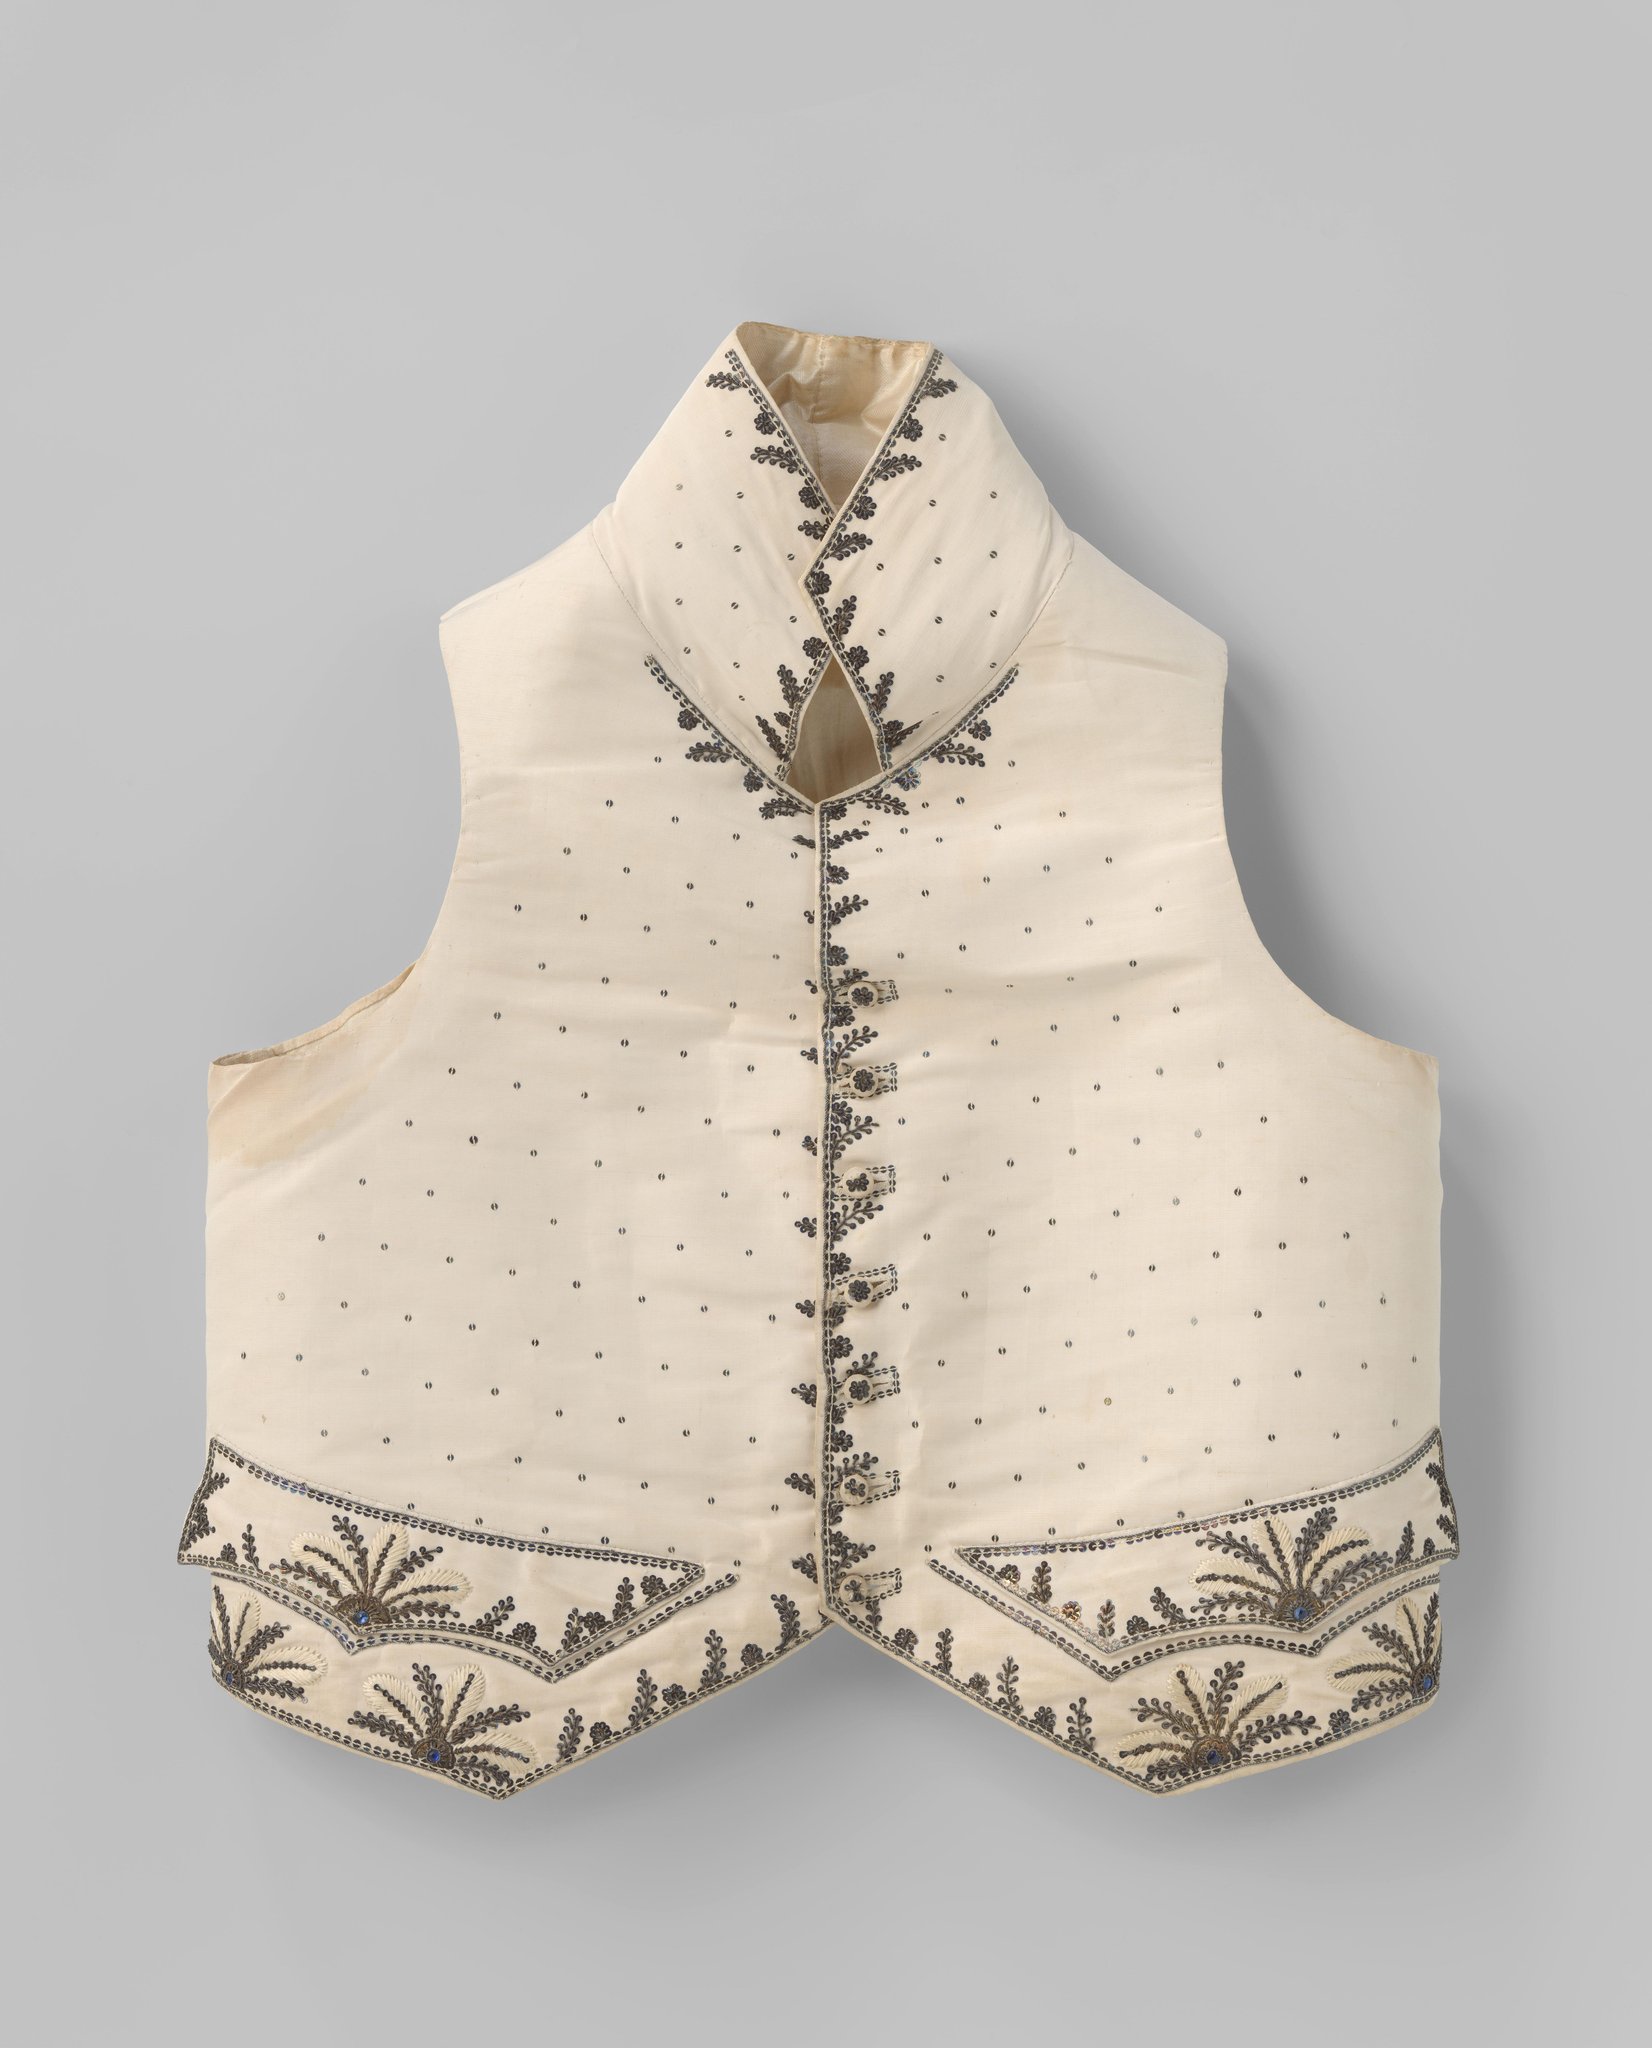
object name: main garment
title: Galavest met hoge staande kraag, schijnzakken met klep en zeven stofknopen van witte ripszijde, geborduurd met zilverkleurige lovertjes, witte zijde en blauwe stenen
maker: Anonymous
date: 1805-1810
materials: linen, silk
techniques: embroidered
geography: amsterdam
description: Galavest van witte ripszijde, gebroduurd met zilveren lovertjes, witte zijde en bauwe stenen. Model: kort, recht, met schuin weggesneden hoeken, hoge staande kraag, zeven stofknoopjes, brede, maar loze zakken met hoe geschulpte kleppen. Patroon v.h. bord w. voorzijde geheel bestrooid met losse lovertjes. Randen met blad en rozetje, met de nerven van cannetille, kleppen en odnerranken met palmetmotief in welks hart een blauw steentje zit. Voering: Voorpanden met grof wit linnenl. Hele rug van fijn wit linnen, met bandjes om te vernauwen. Toestand: Voorzijde heel, met trampiratievlekken. Het cannetille is geoxydeerd.